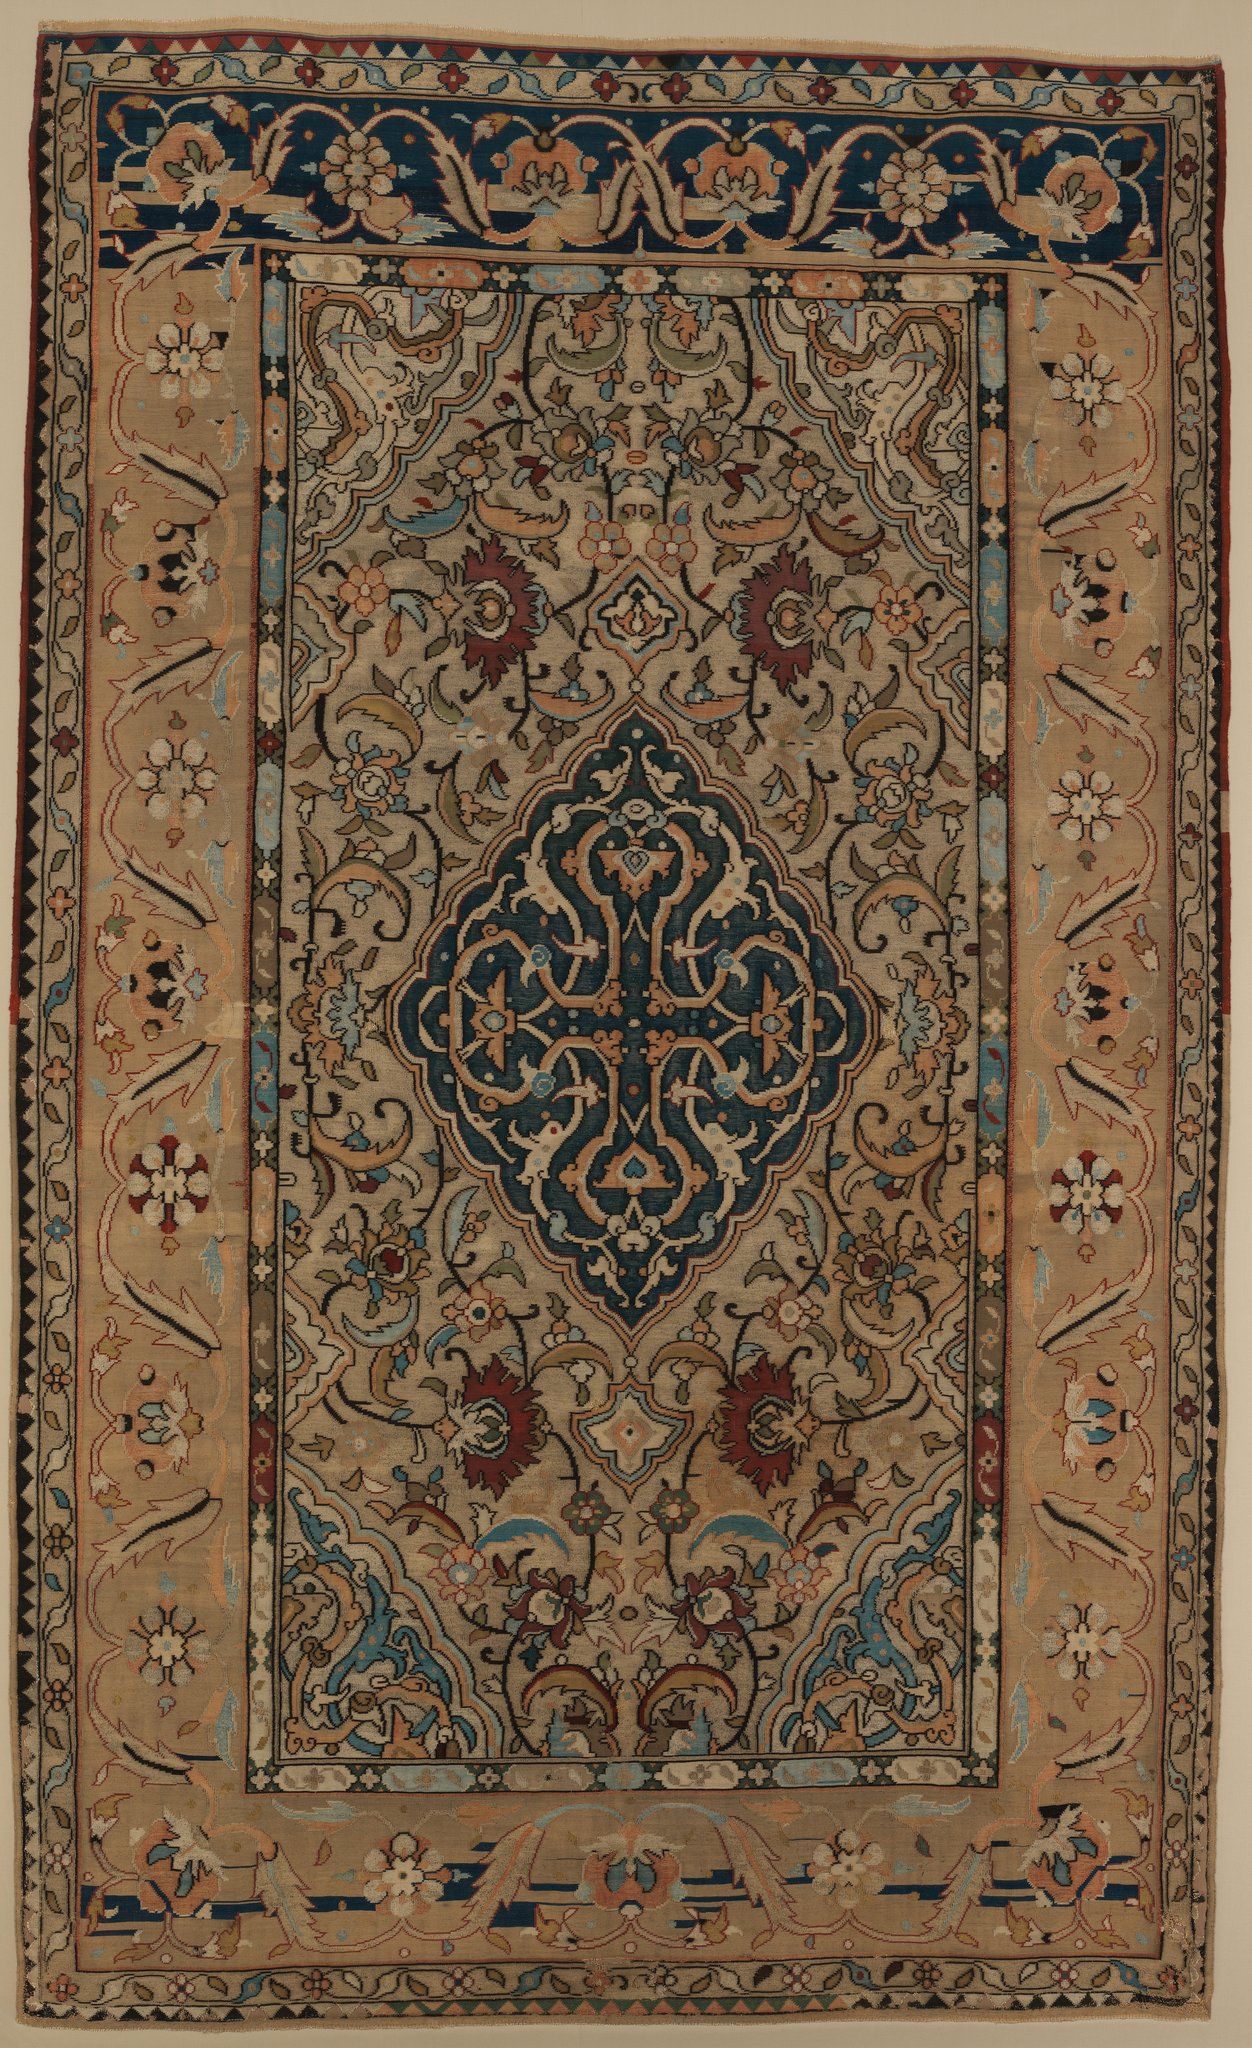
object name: carpet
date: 1567-1633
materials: metal thread, silk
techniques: weave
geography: iran